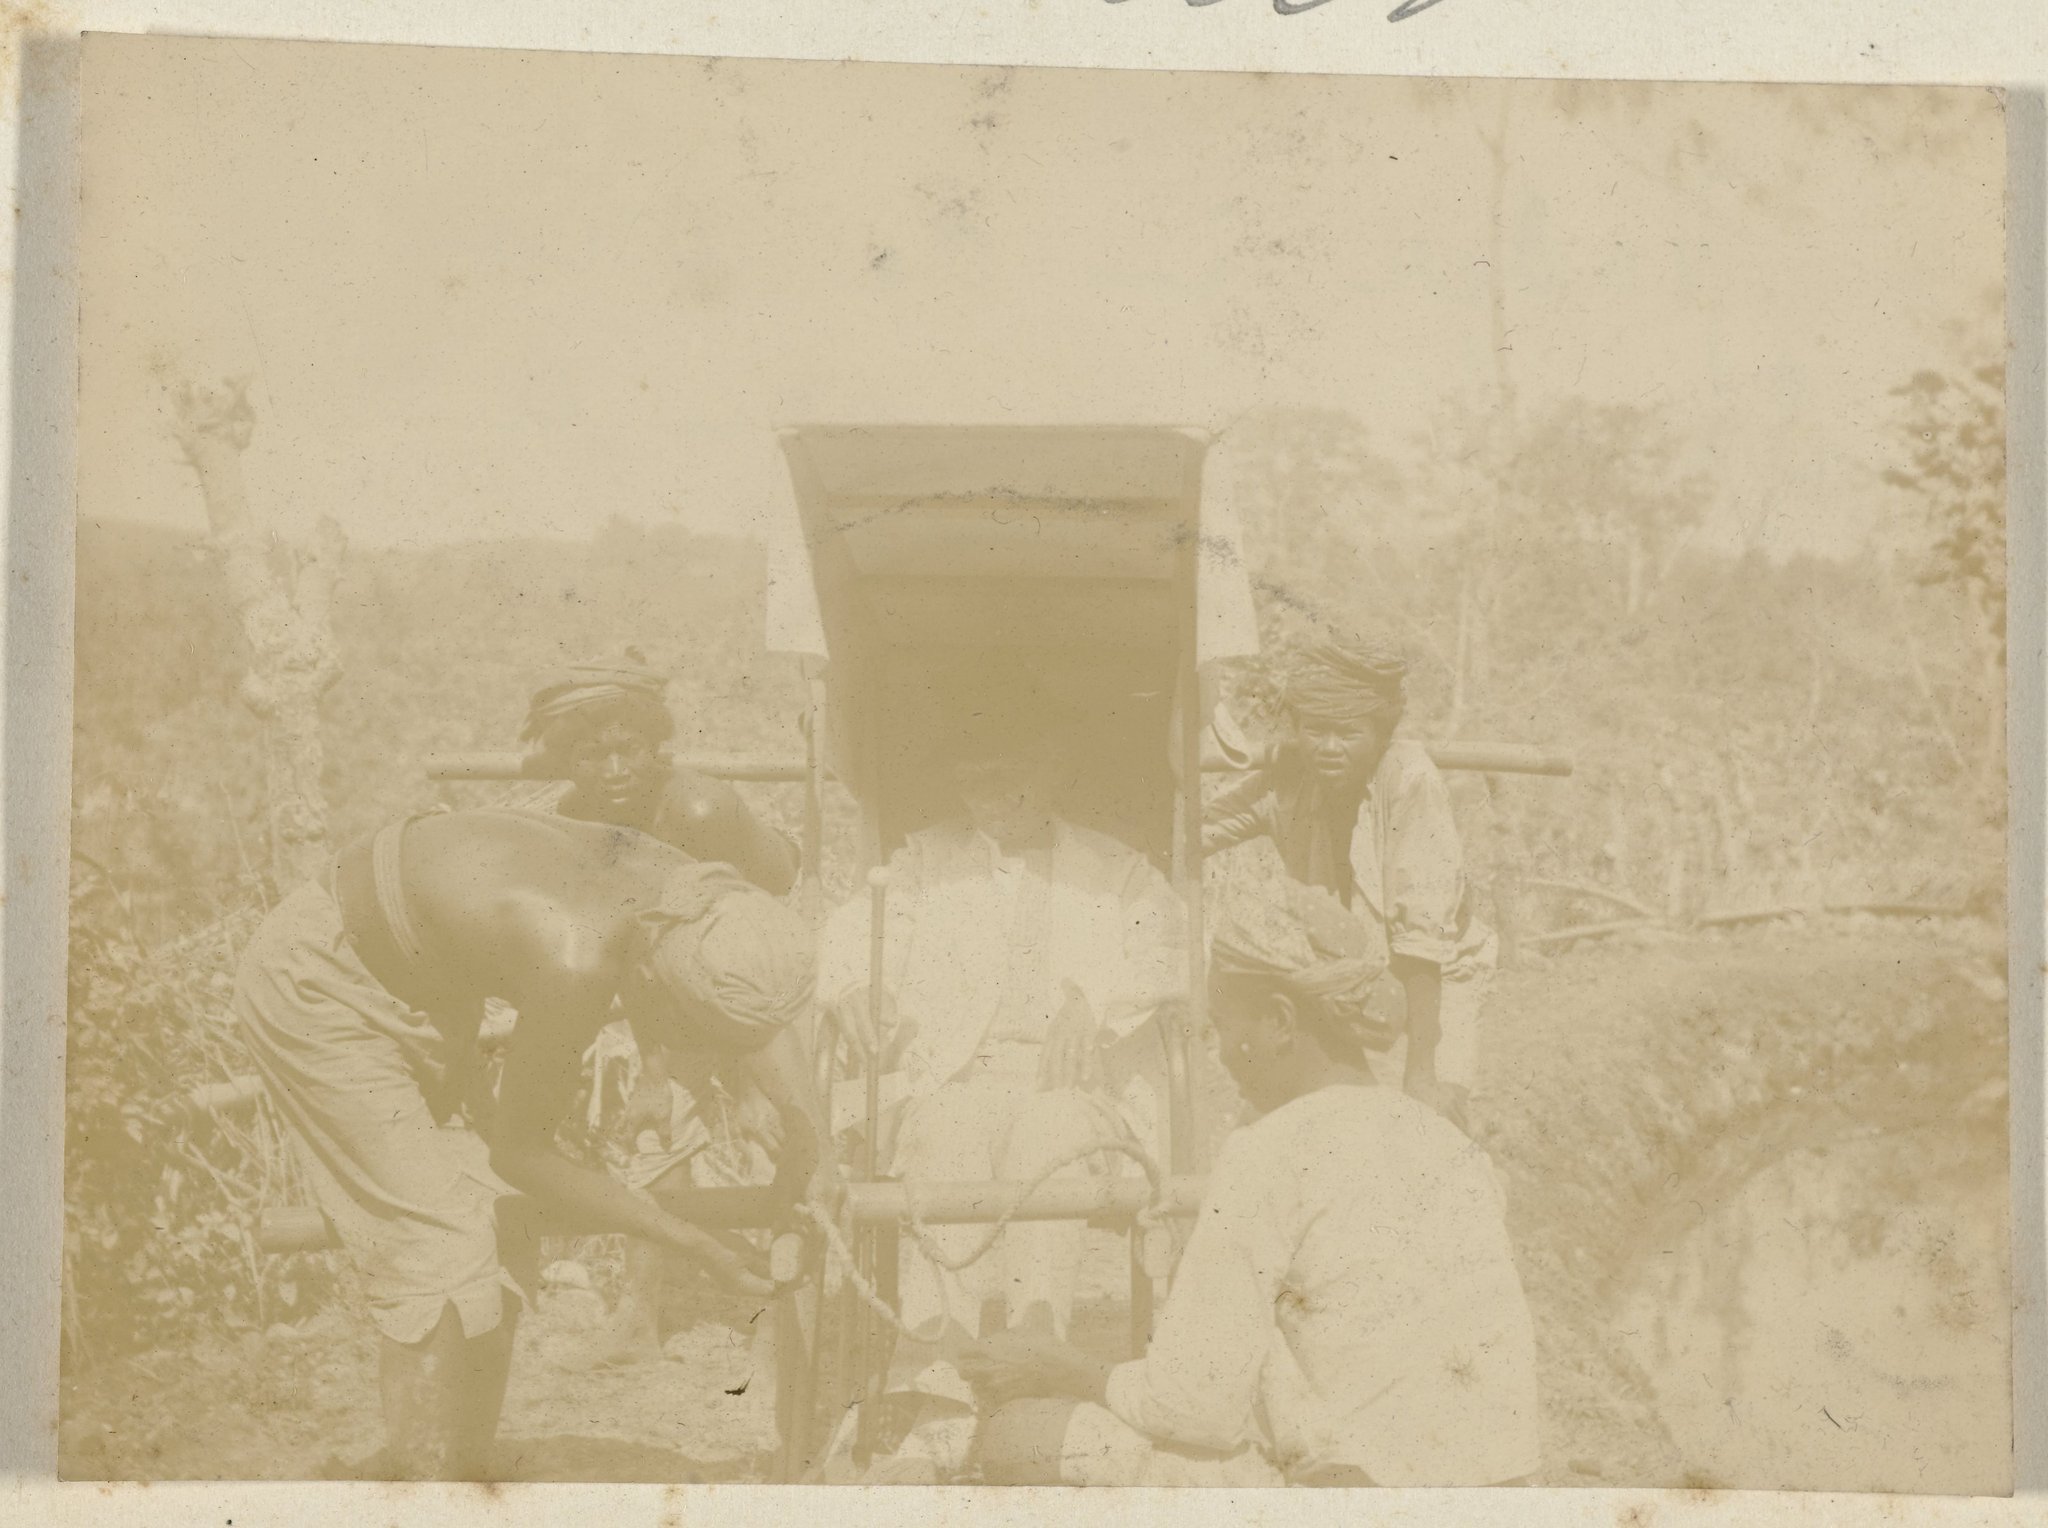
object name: photograph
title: 5 kiekjes te Djattie roenggo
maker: Anonymous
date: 1890-1910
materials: cardboard, paper, photographic support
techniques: gelatin silver print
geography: netherlands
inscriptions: caption: ‘5 kiekjes te Djattie roenggo’